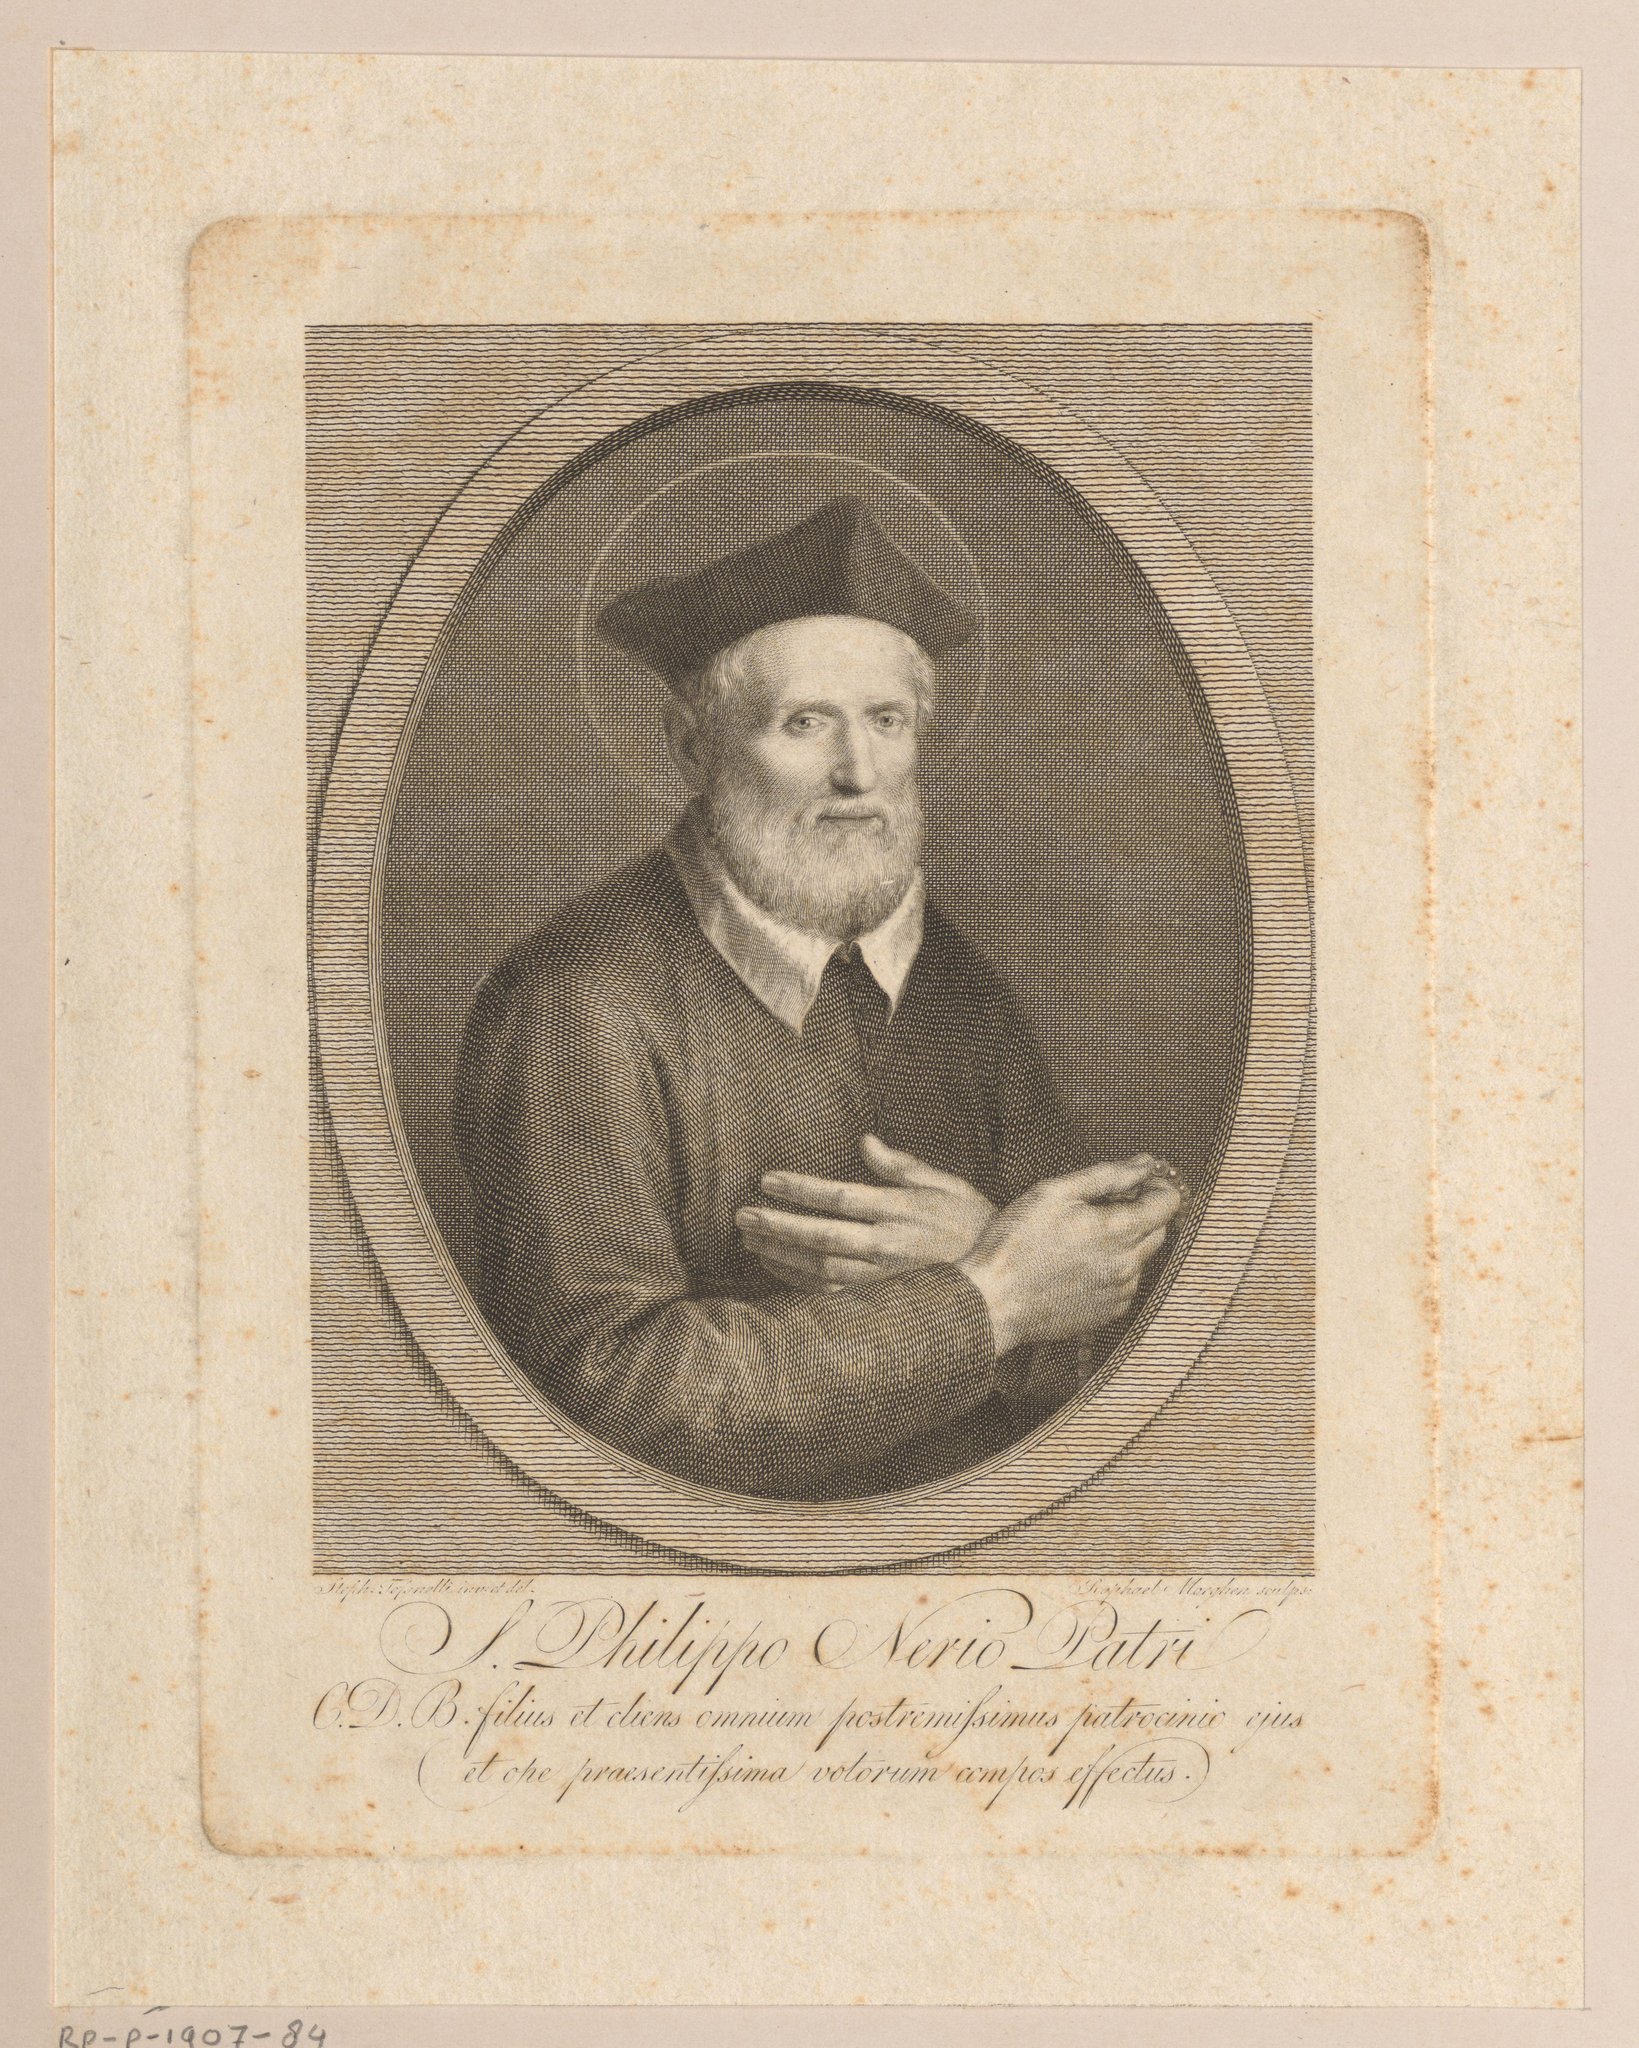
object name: print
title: Portret van Filippo Neri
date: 1768-1833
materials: paper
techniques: engraving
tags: rome, clergyman, priest (roman catholic), historical persons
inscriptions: collector's mark: Lugt 2228